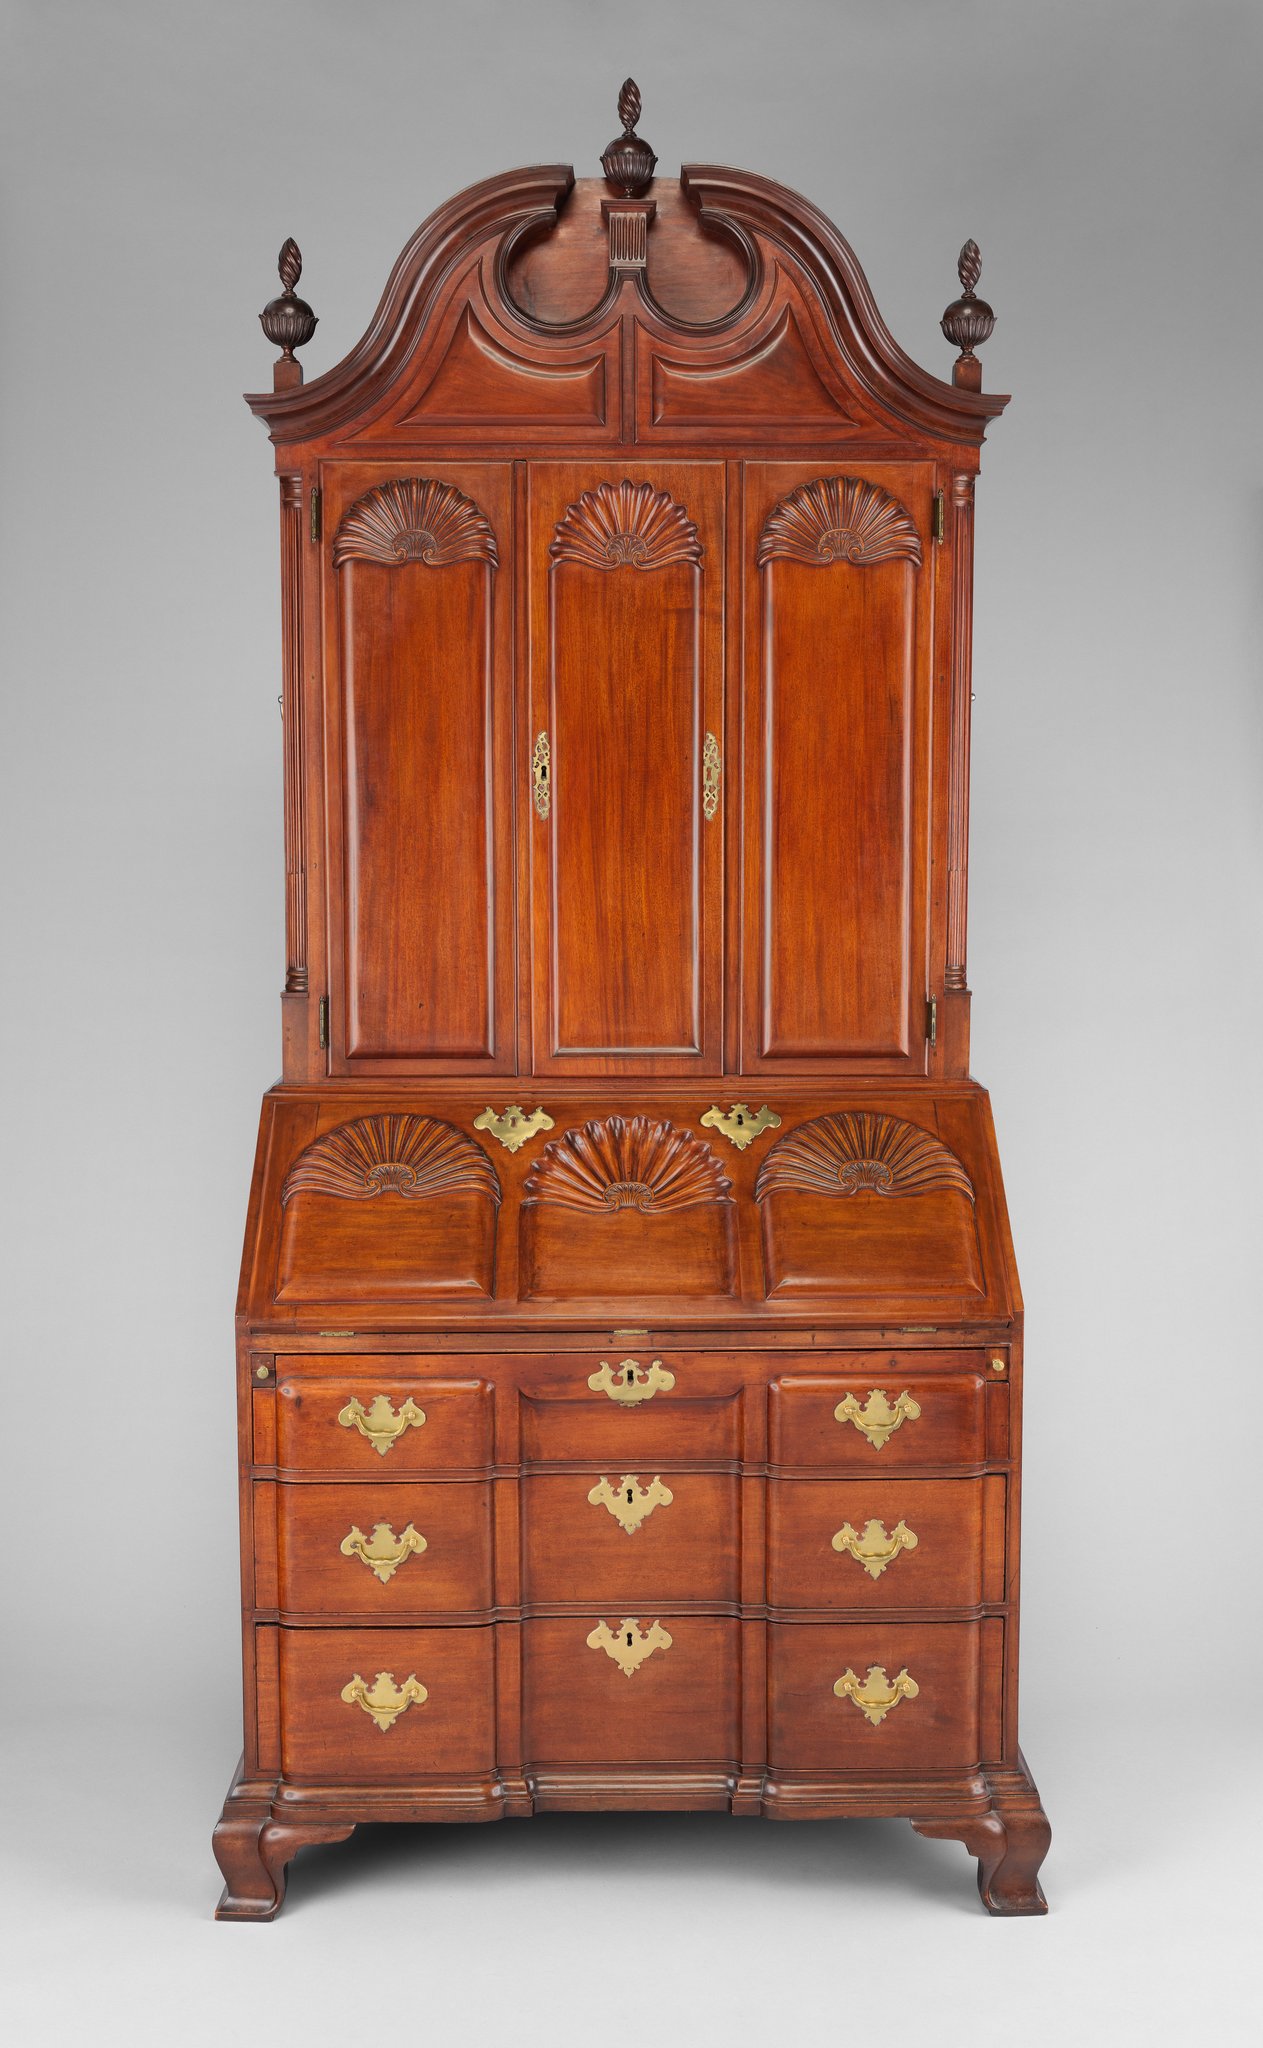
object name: desk and bookcase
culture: american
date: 1760-1790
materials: brass, wood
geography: united states